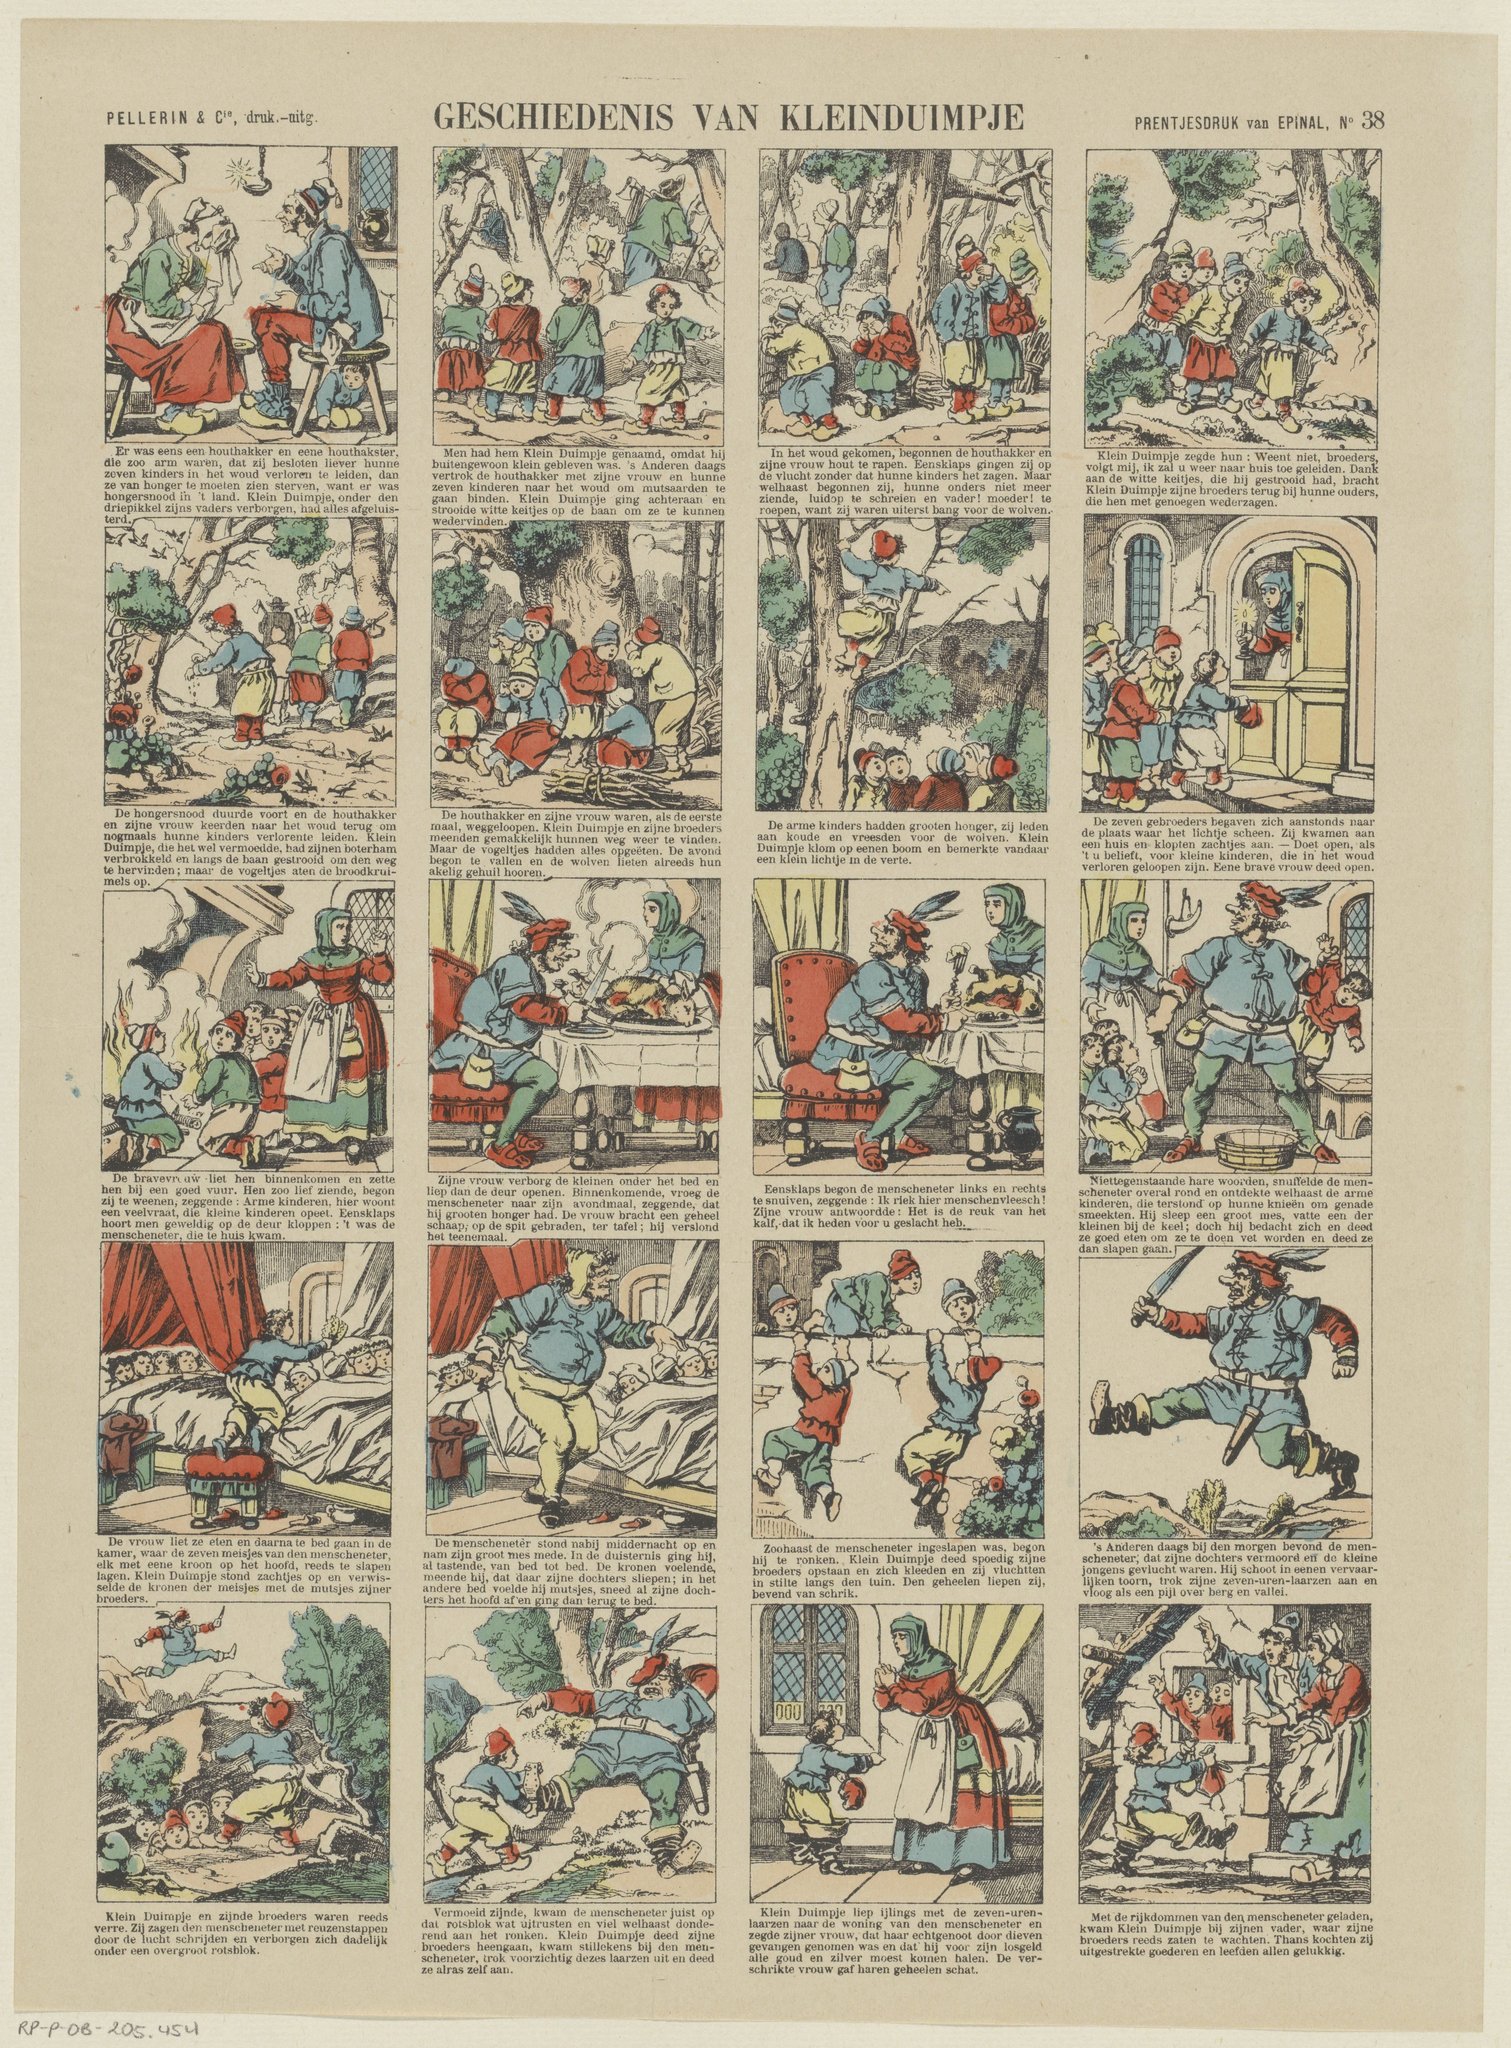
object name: print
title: Geschiedenis van Klein Duimpje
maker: Anonymous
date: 1902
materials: paper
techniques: colour, letterpress printing, lithograph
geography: epinal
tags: tales and fairy tales: little thumbling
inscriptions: collector's mark: Lugt 2760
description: Blad met 20 voorstellingen uit het sprookje van Klein Duimpje. Onder elke afbeelding een onderschrift. Genummerd rechtsboven: No 38.